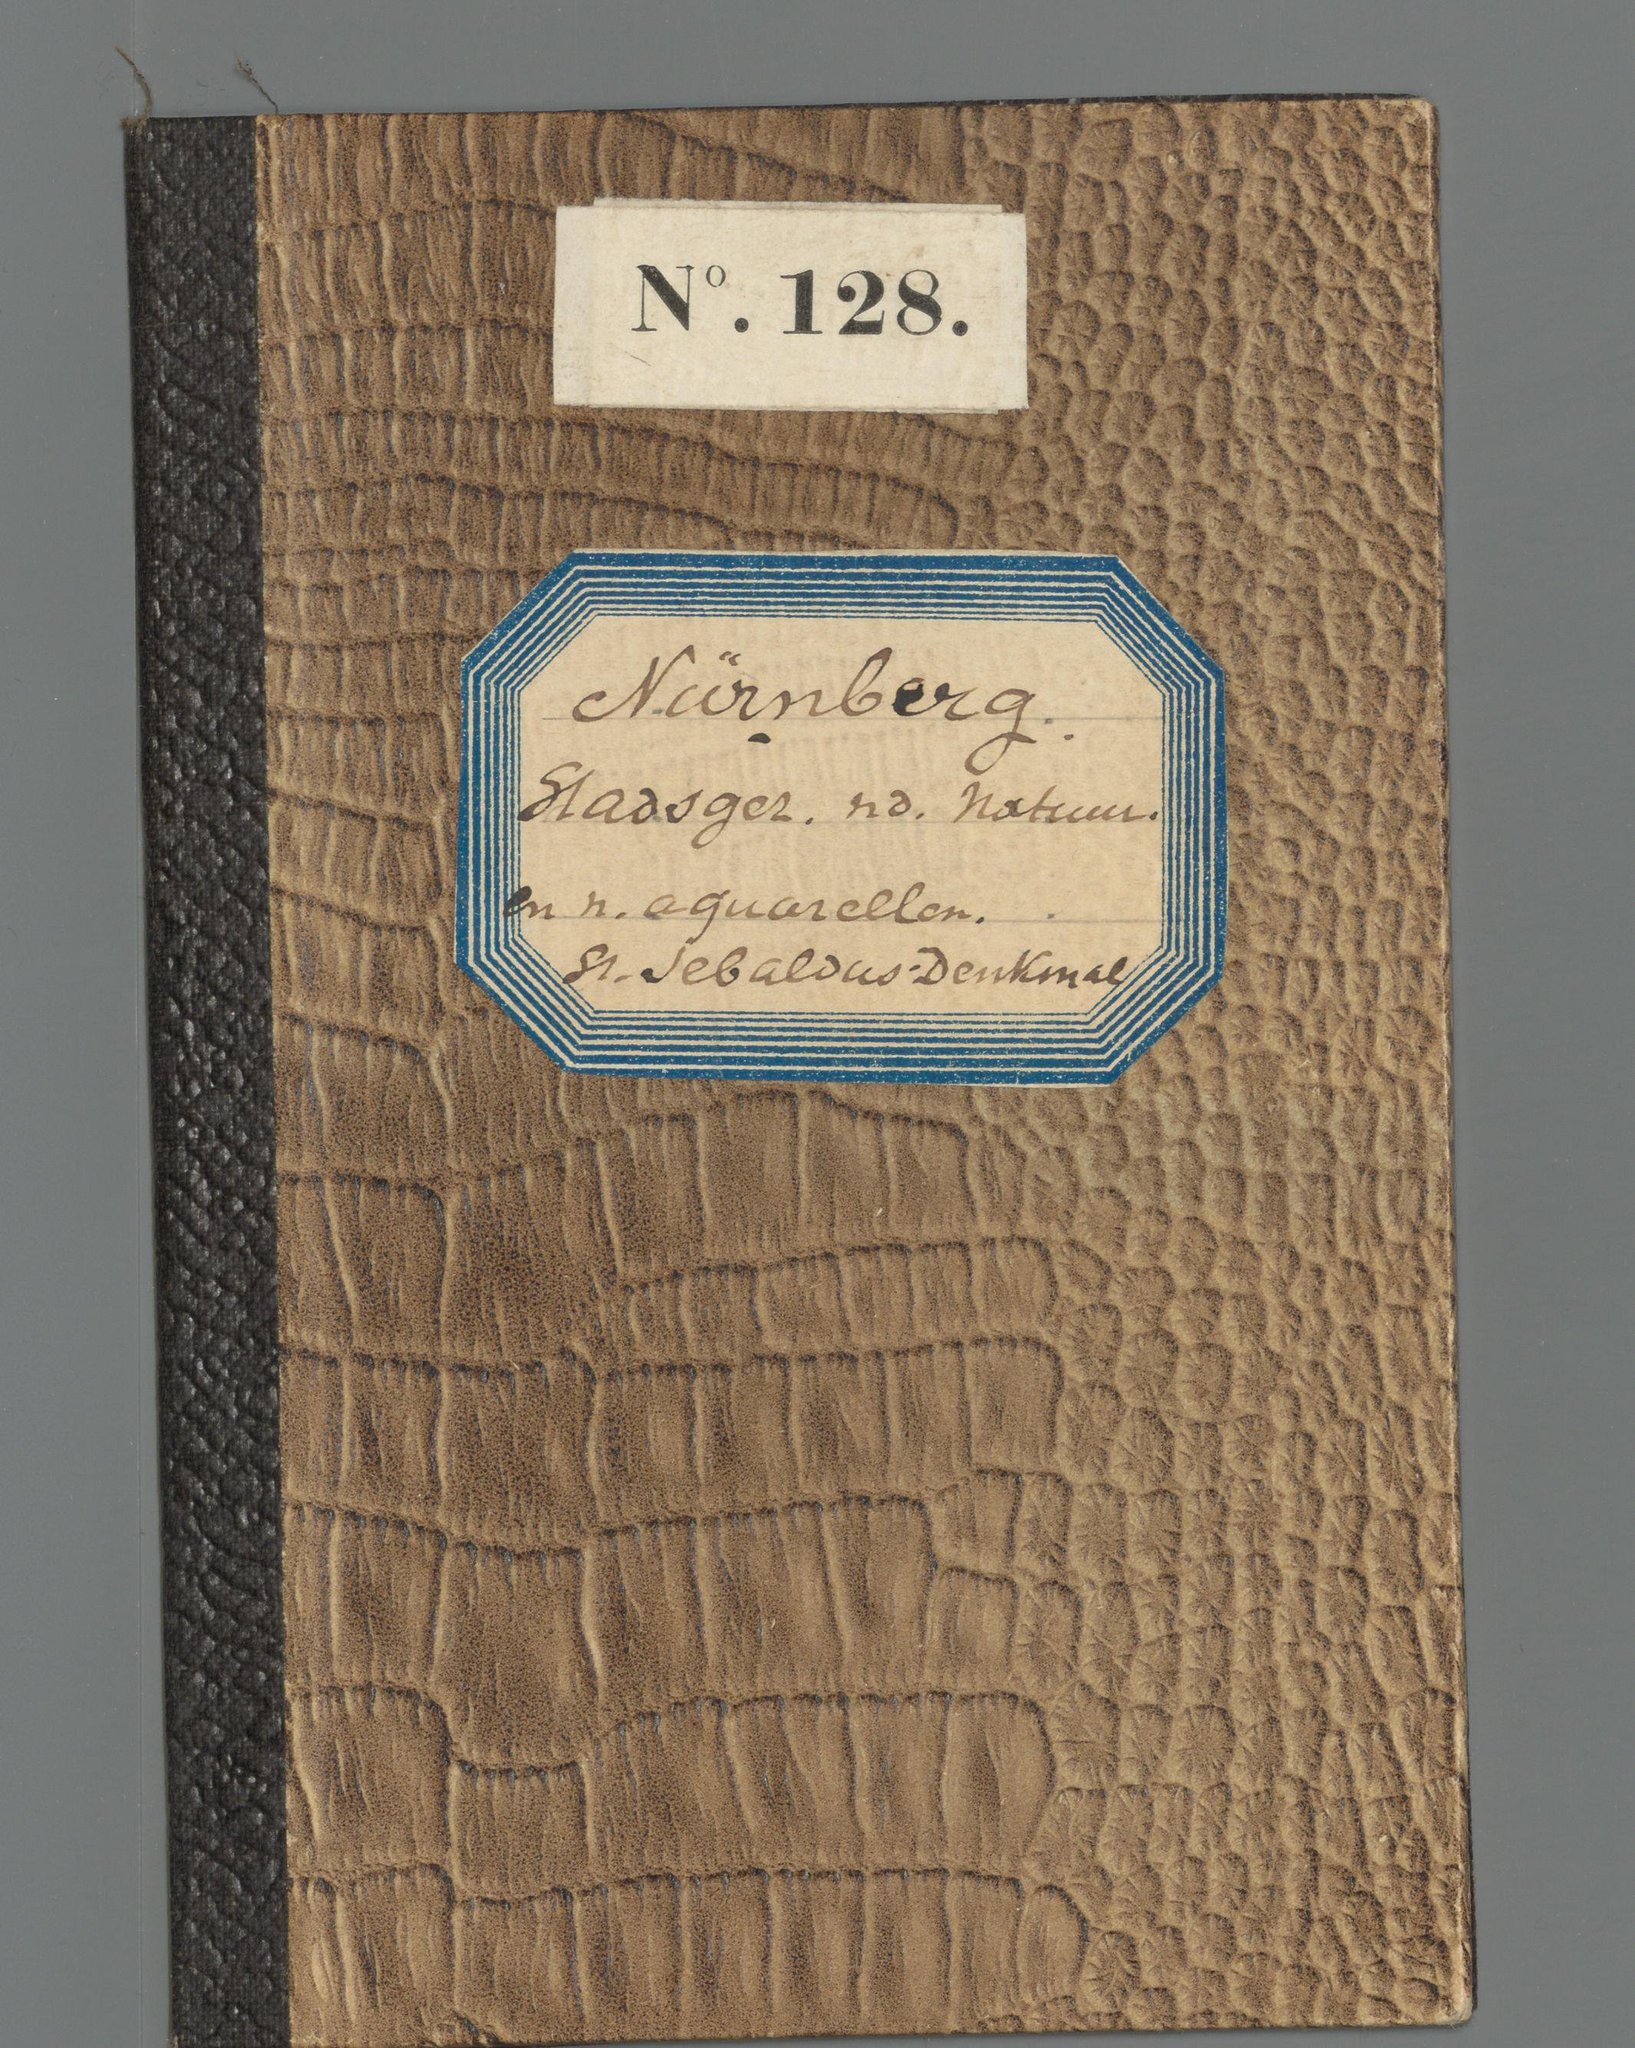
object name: wrapper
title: Omslag voor 21 prentbriefkaarten met stadsgezichten uit Neurenberg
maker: Anonymous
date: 1900-1950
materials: cardboard, paper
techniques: lithograph, writing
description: In de omslag zit een kaart ingestoken met daarop een korte beschrijving van de inhoud.